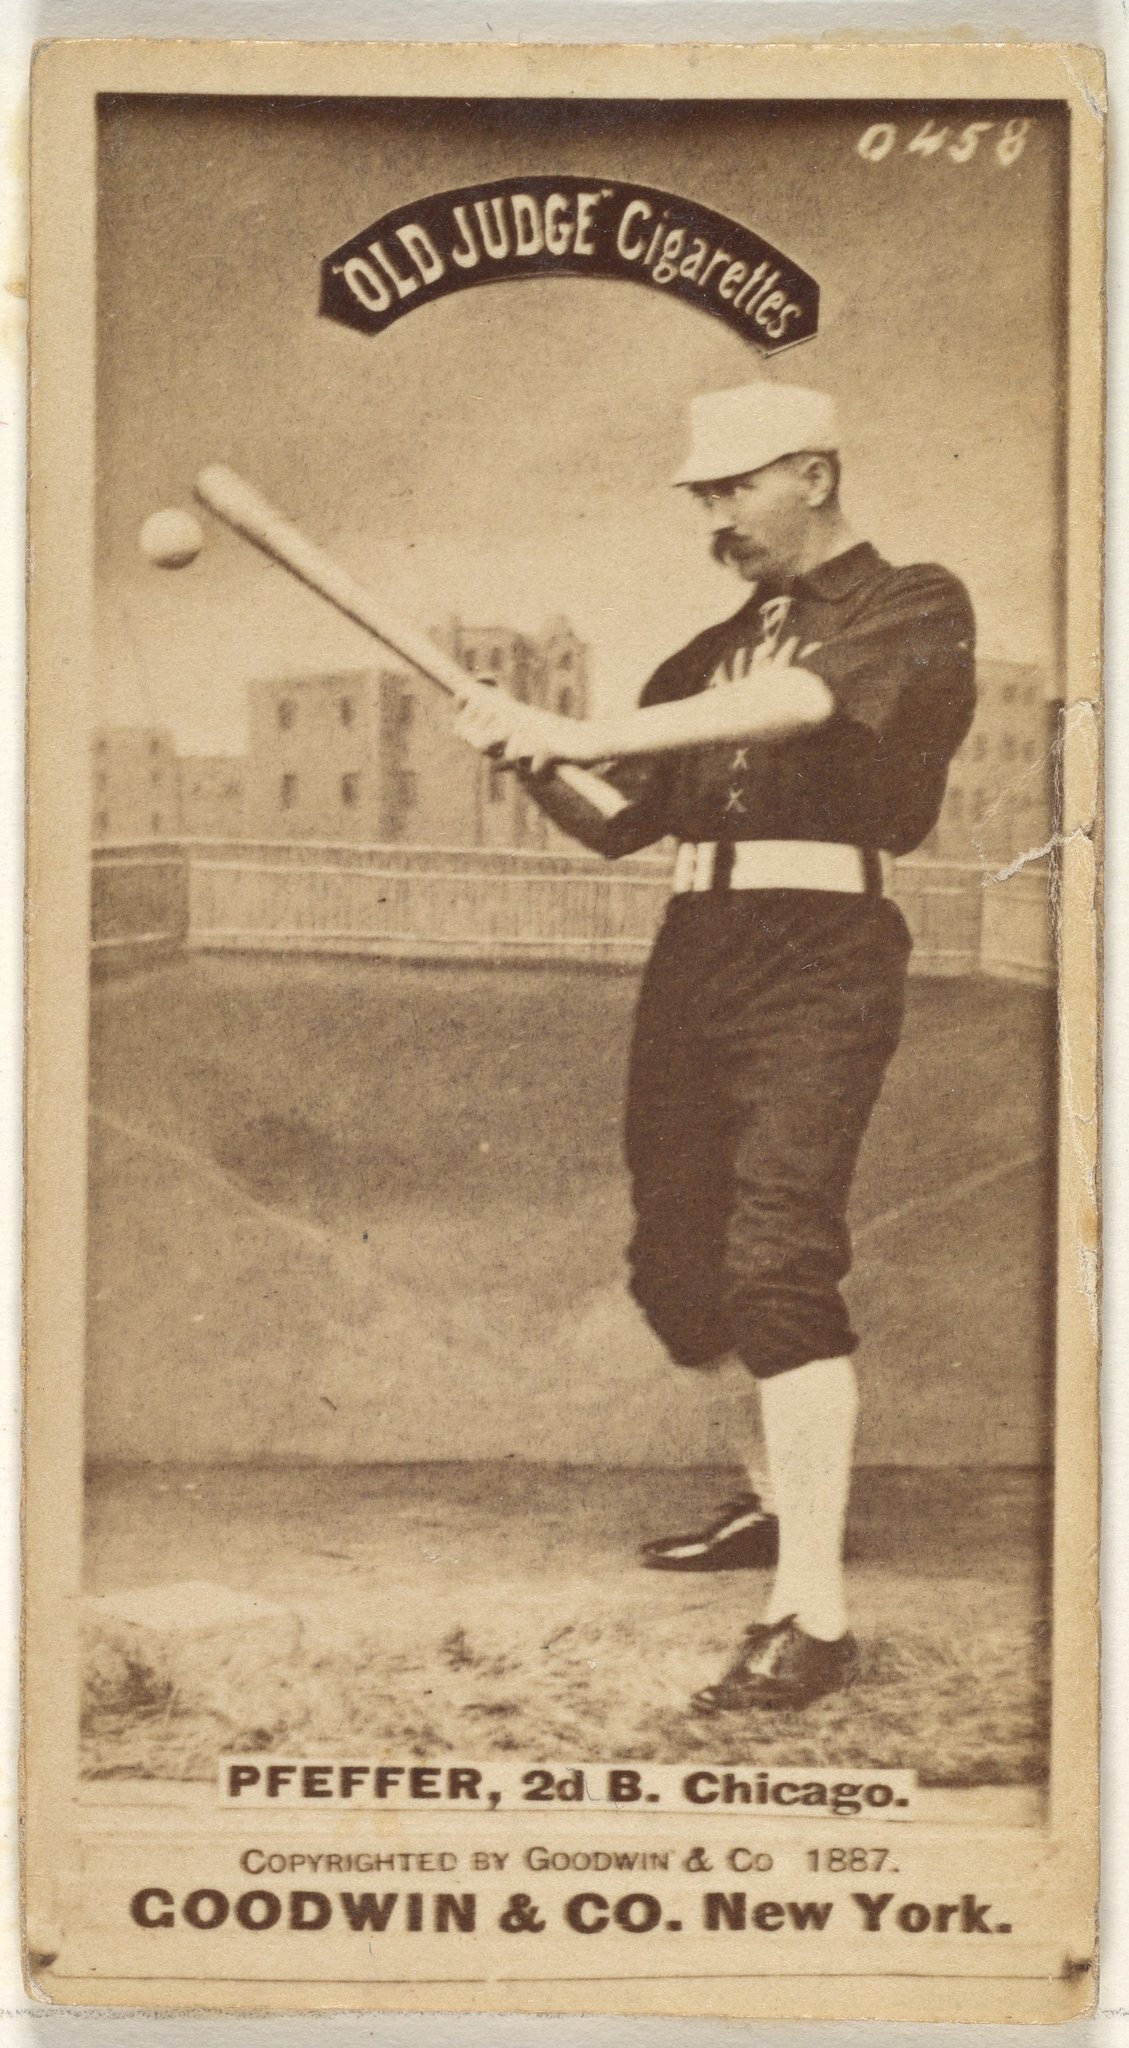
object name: baseball card, photograph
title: Fred "Dandelion" Pfeffer, 2nd Base, Chicago, from the Old Judge series (N172) for Old Judge Cigarettes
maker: goodwin & company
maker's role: publisher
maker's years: 1850-1950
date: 1887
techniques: albumen silver print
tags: men,portraits,baseball,athletes